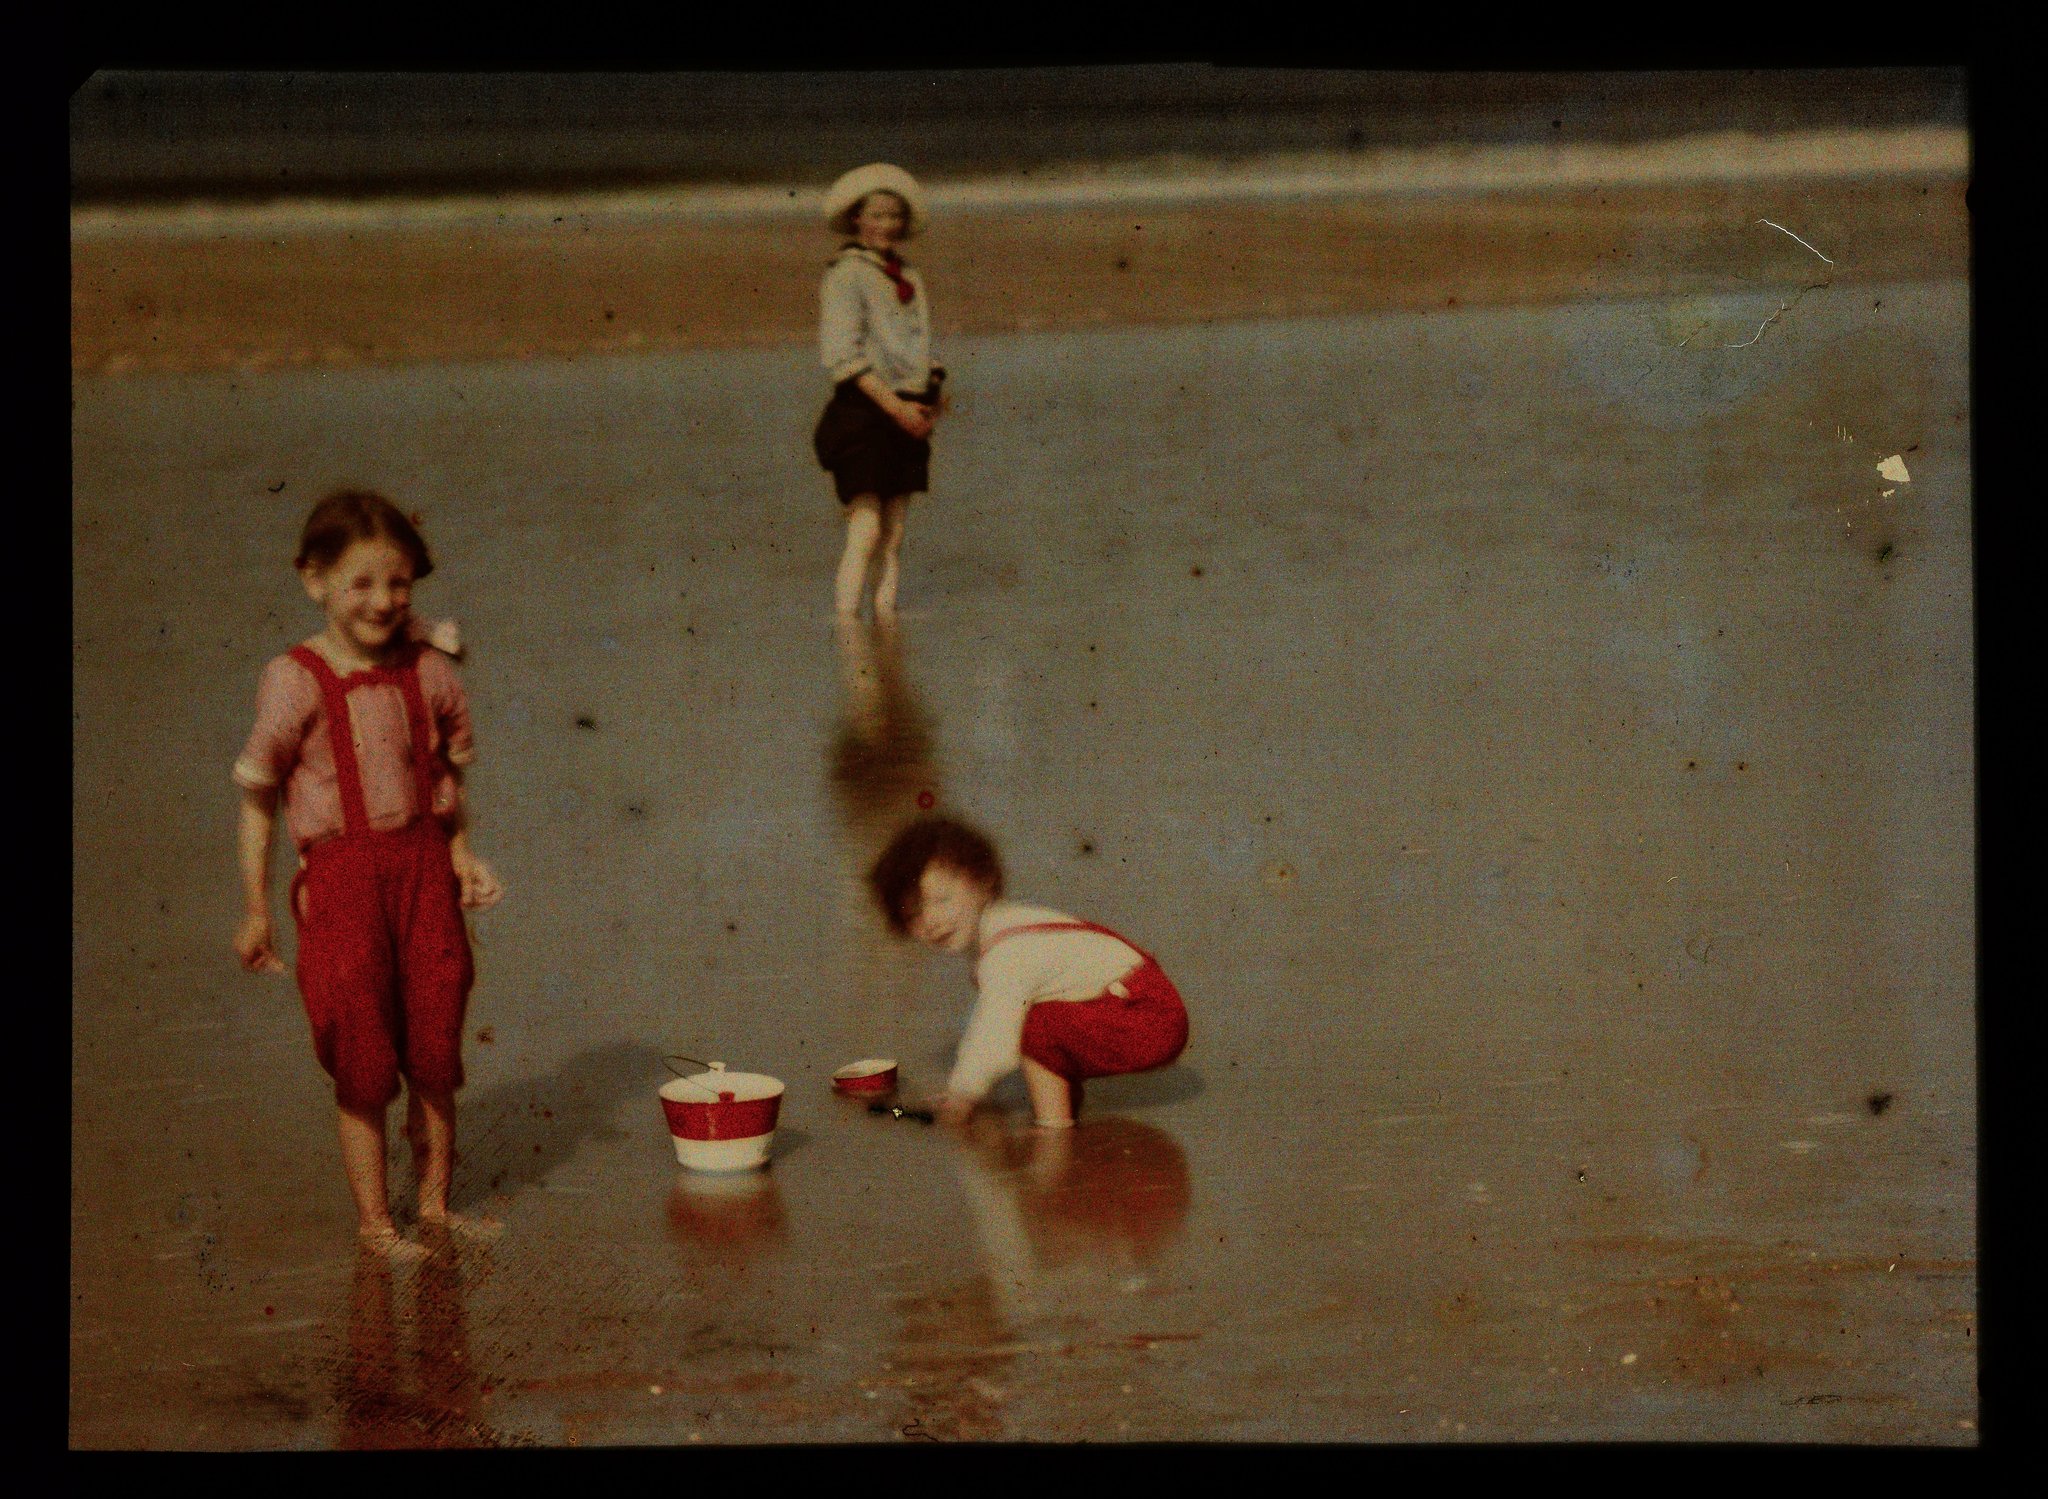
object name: glasdia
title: Drie kinderen spelend aan het Noordzeestrand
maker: adolphe burdet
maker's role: fotograaf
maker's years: 1860-1940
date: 1907-1930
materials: glass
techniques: autochrome process, slide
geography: netherlands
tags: noordzee